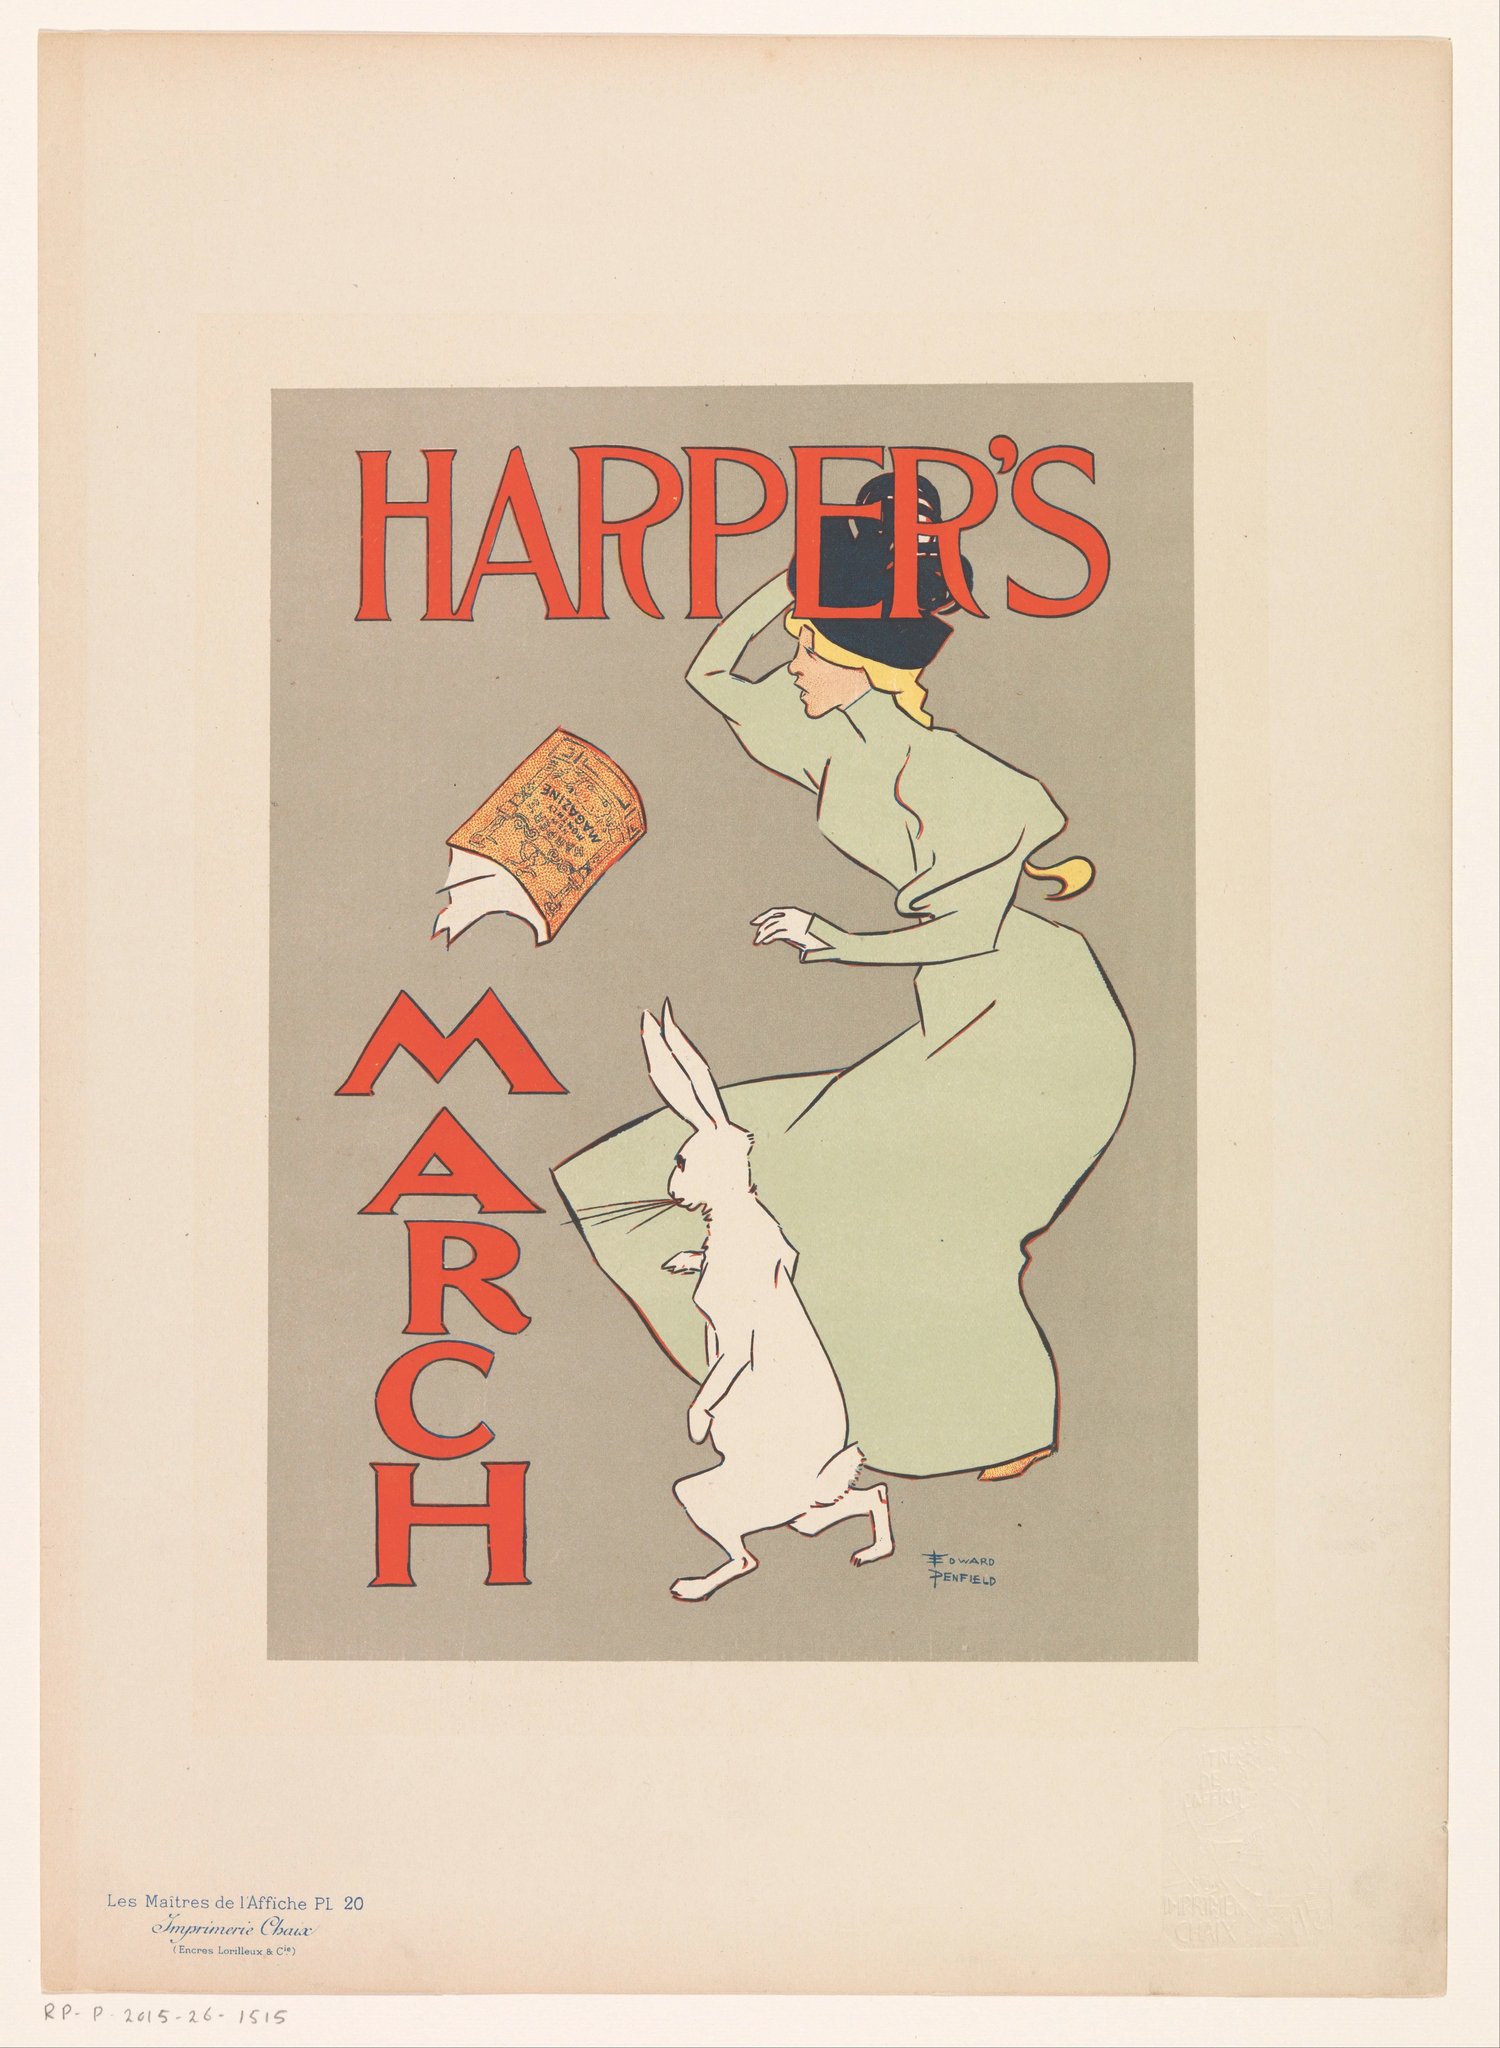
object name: print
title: Les Maîtres de l'Affiche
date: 1895-1900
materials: paper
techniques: lithograph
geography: paris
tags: weekly, monthly, magazine, etc., rodents: rabbit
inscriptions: stamp: Lugt 1777c, collector's mark: Lugt 4780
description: Een vrouw met een konijn, door de lucht vliegt een exemplaar van het tijdschrift.